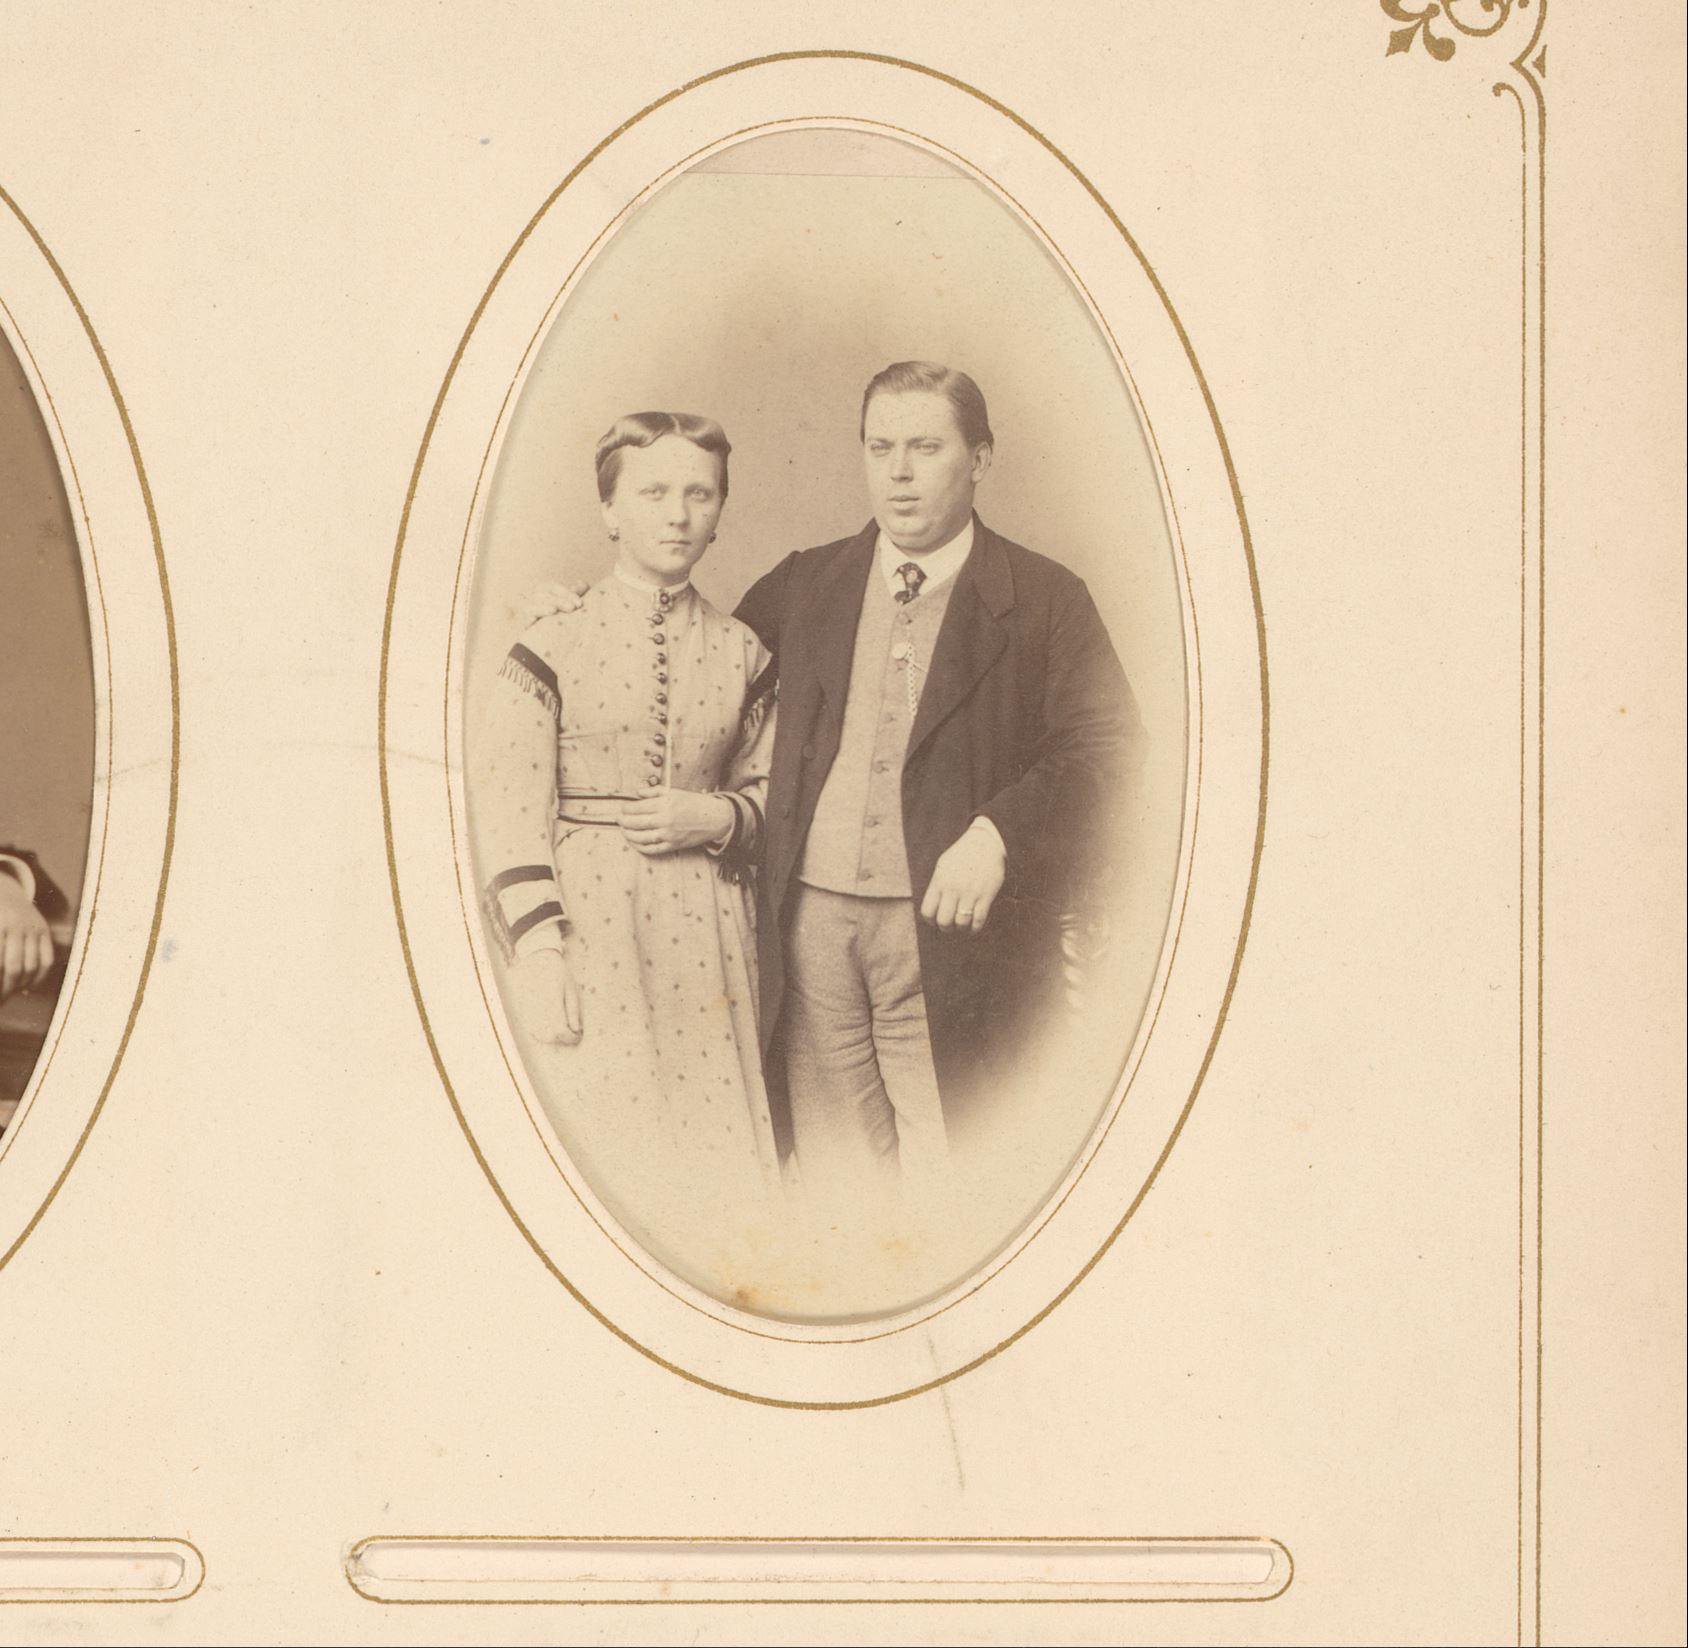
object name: carte de visite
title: Portret van een vrouw en een man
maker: a.h. burdorf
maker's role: fotograaf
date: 1850-1900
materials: cardboard, photographic support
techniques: albumen print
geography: hildesheim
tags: historical persons - bb - woman, historical persons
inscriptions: inscription: ‘Photographische Anstalt/ A. H. BURDORF/ HILDESHEIM/ Neue Osterstrasse No 10.’, annotation: ‘Mutters [reltem]/ als Brantleute’